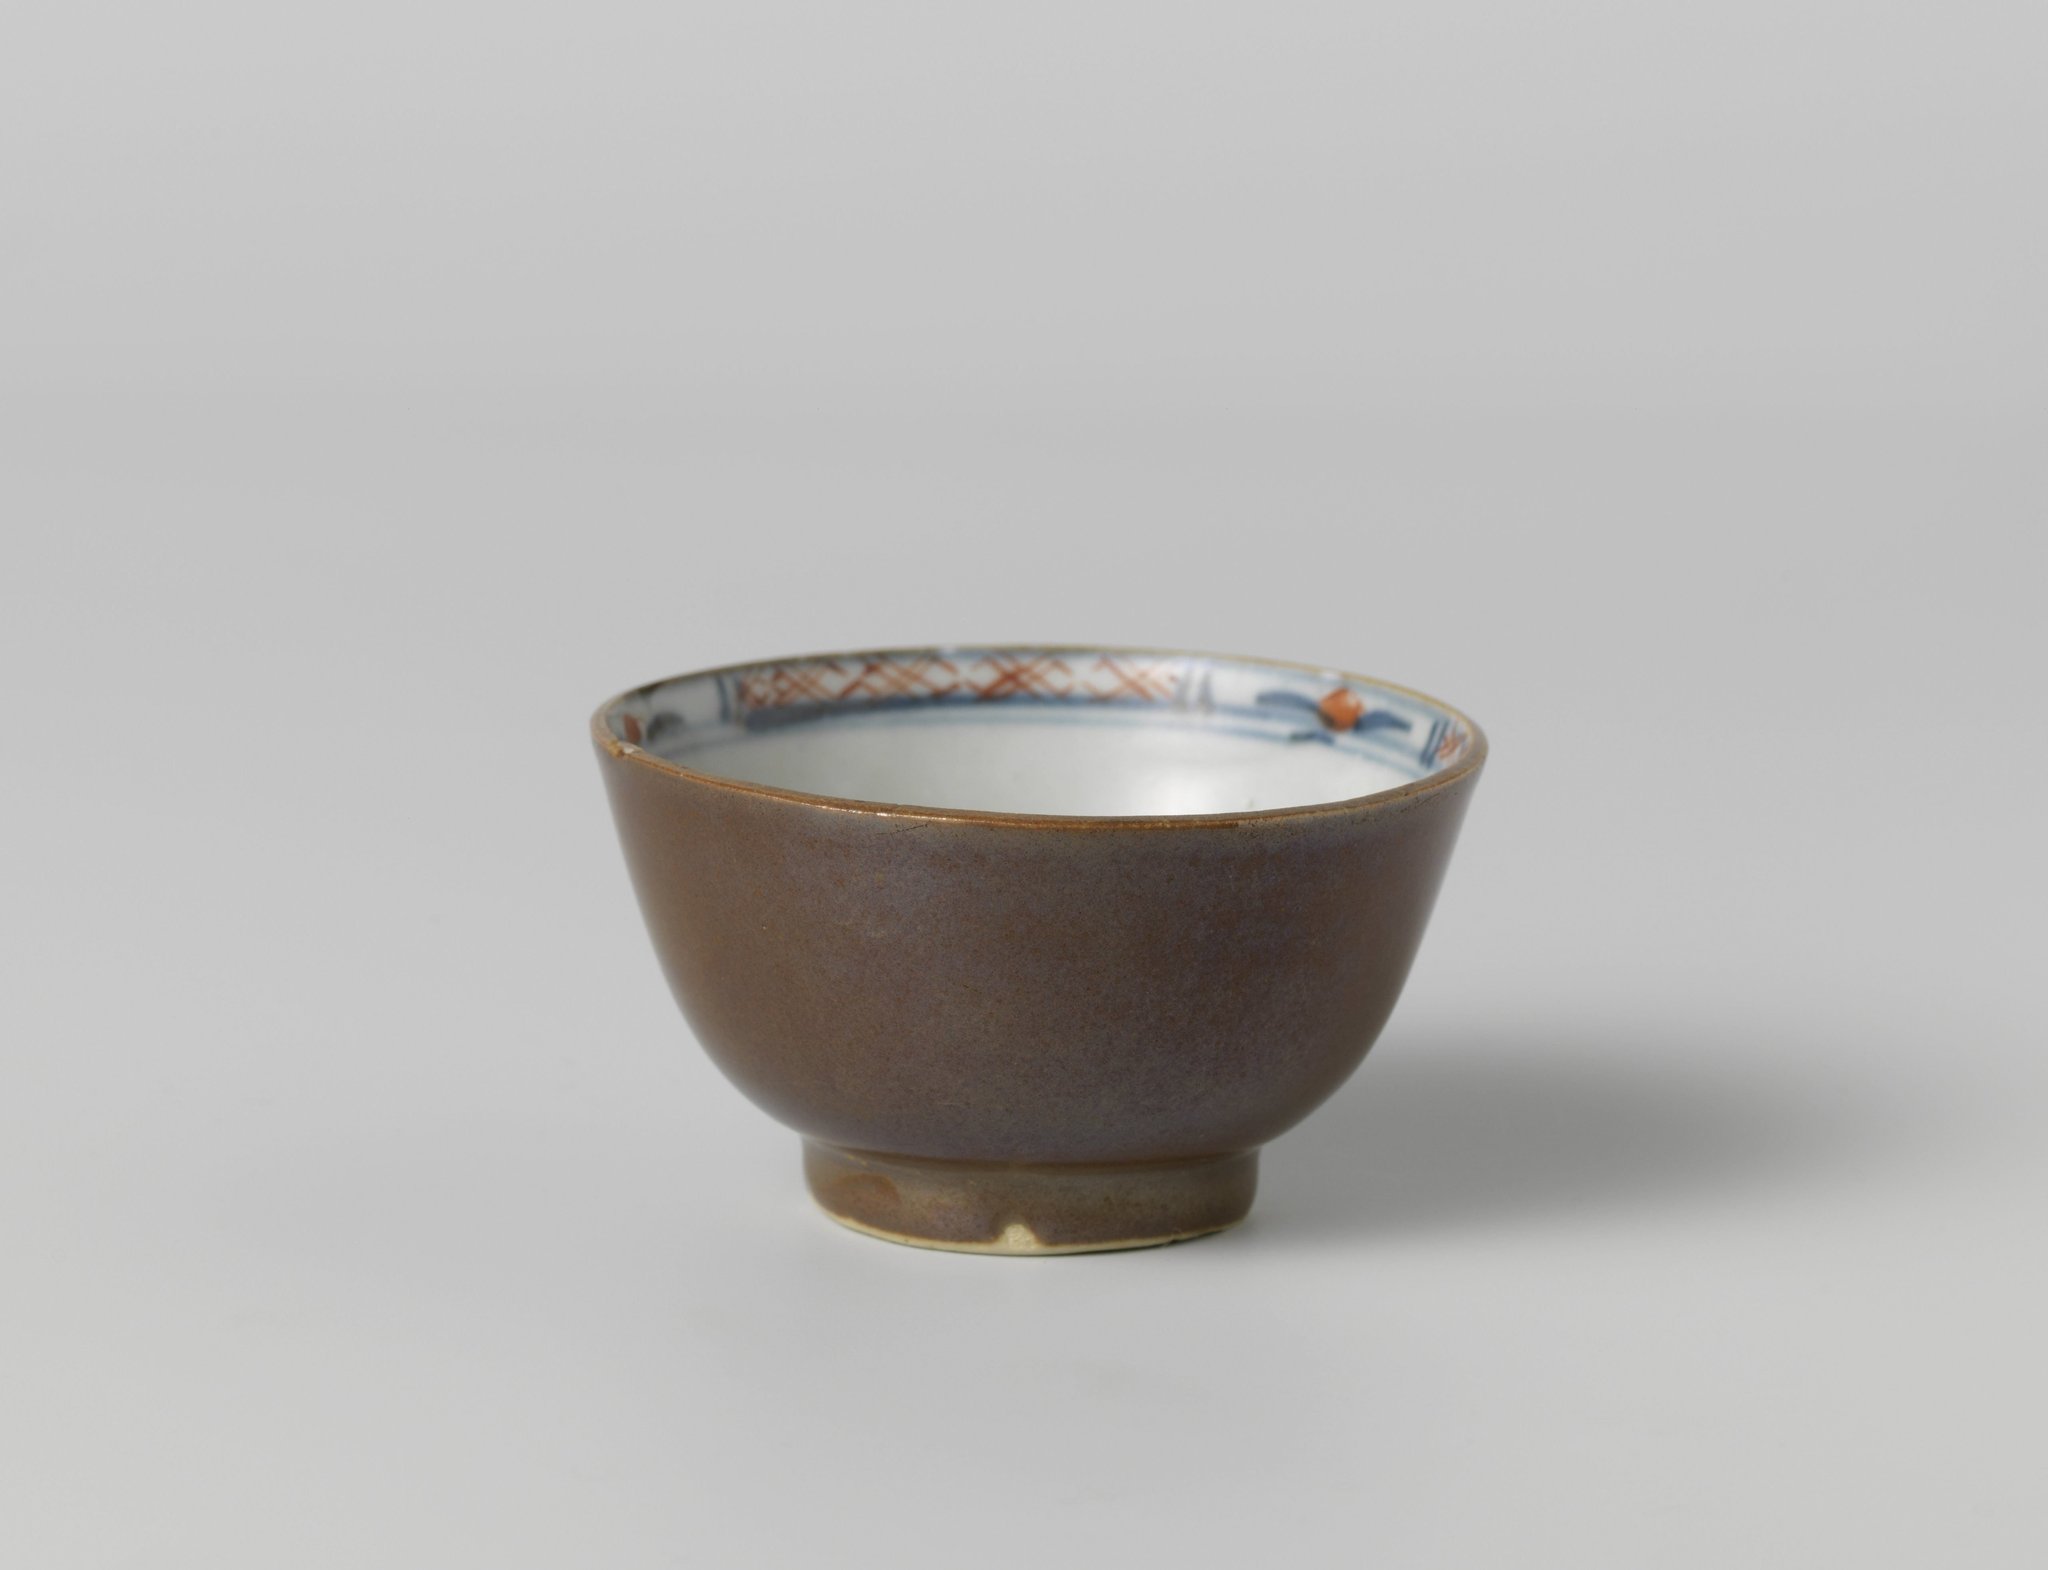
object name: kop en schotel, kop en schotel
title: Cup with flower sprays near a rock and a dark brown glaze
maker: Anonymous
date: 1730-1770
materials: cobalt, glaze, gold, paint, porcelain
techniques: firing, gilding, turning, vitrification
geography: china